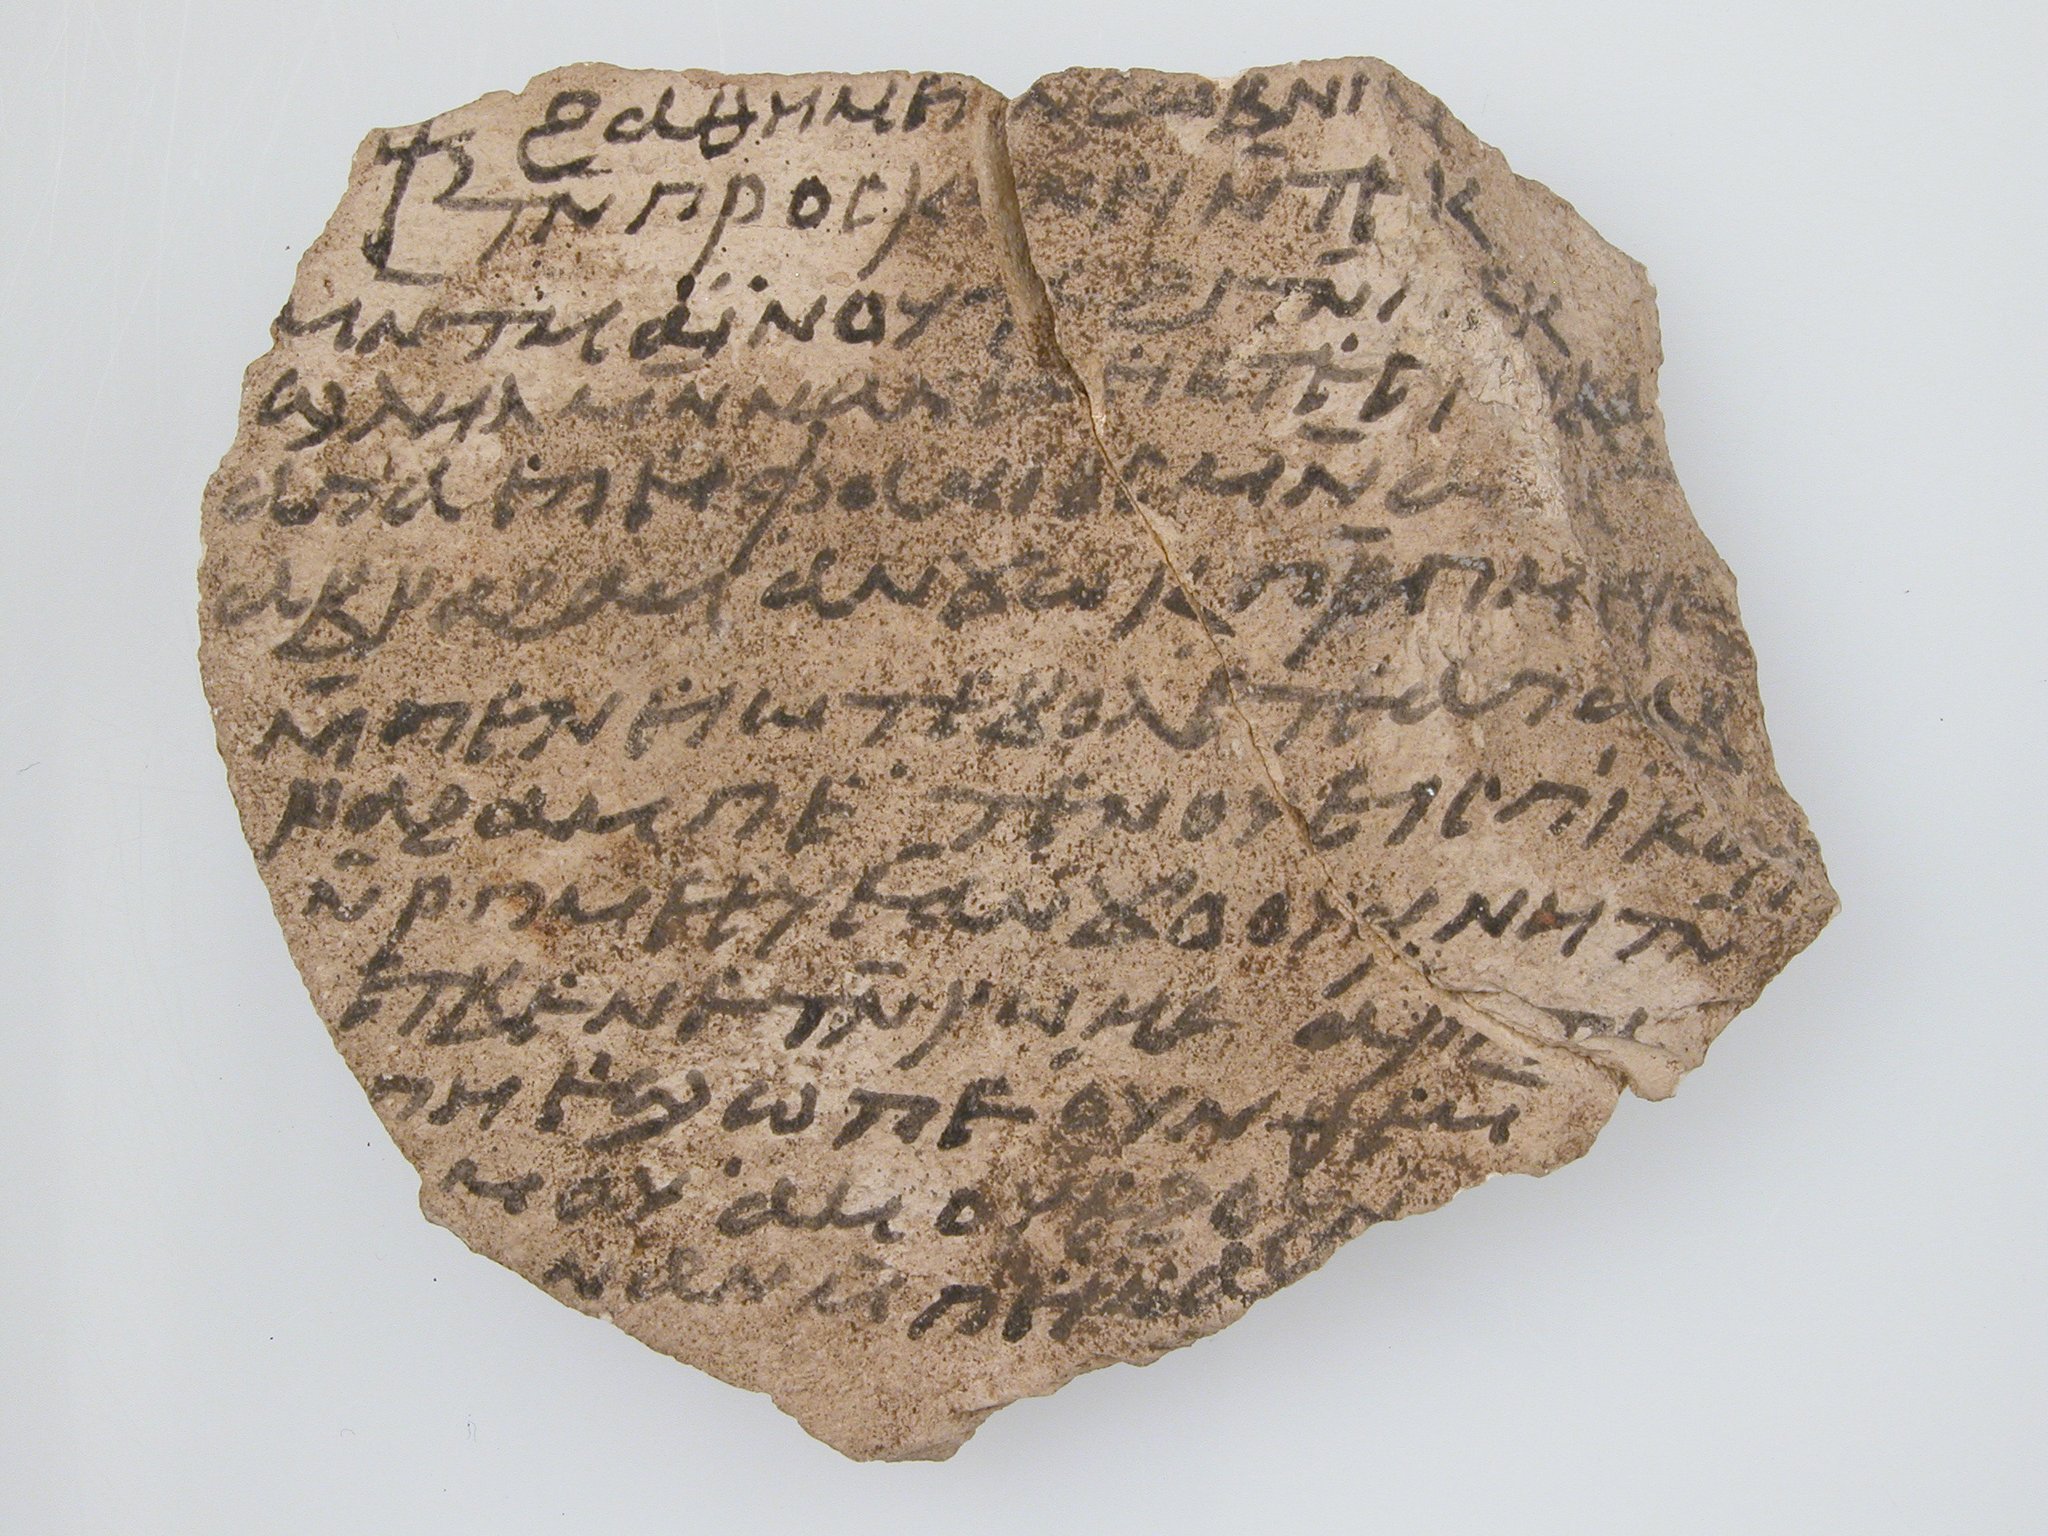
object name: ostrakon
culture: coptic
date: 601-700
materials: ink, limestone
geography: egypt